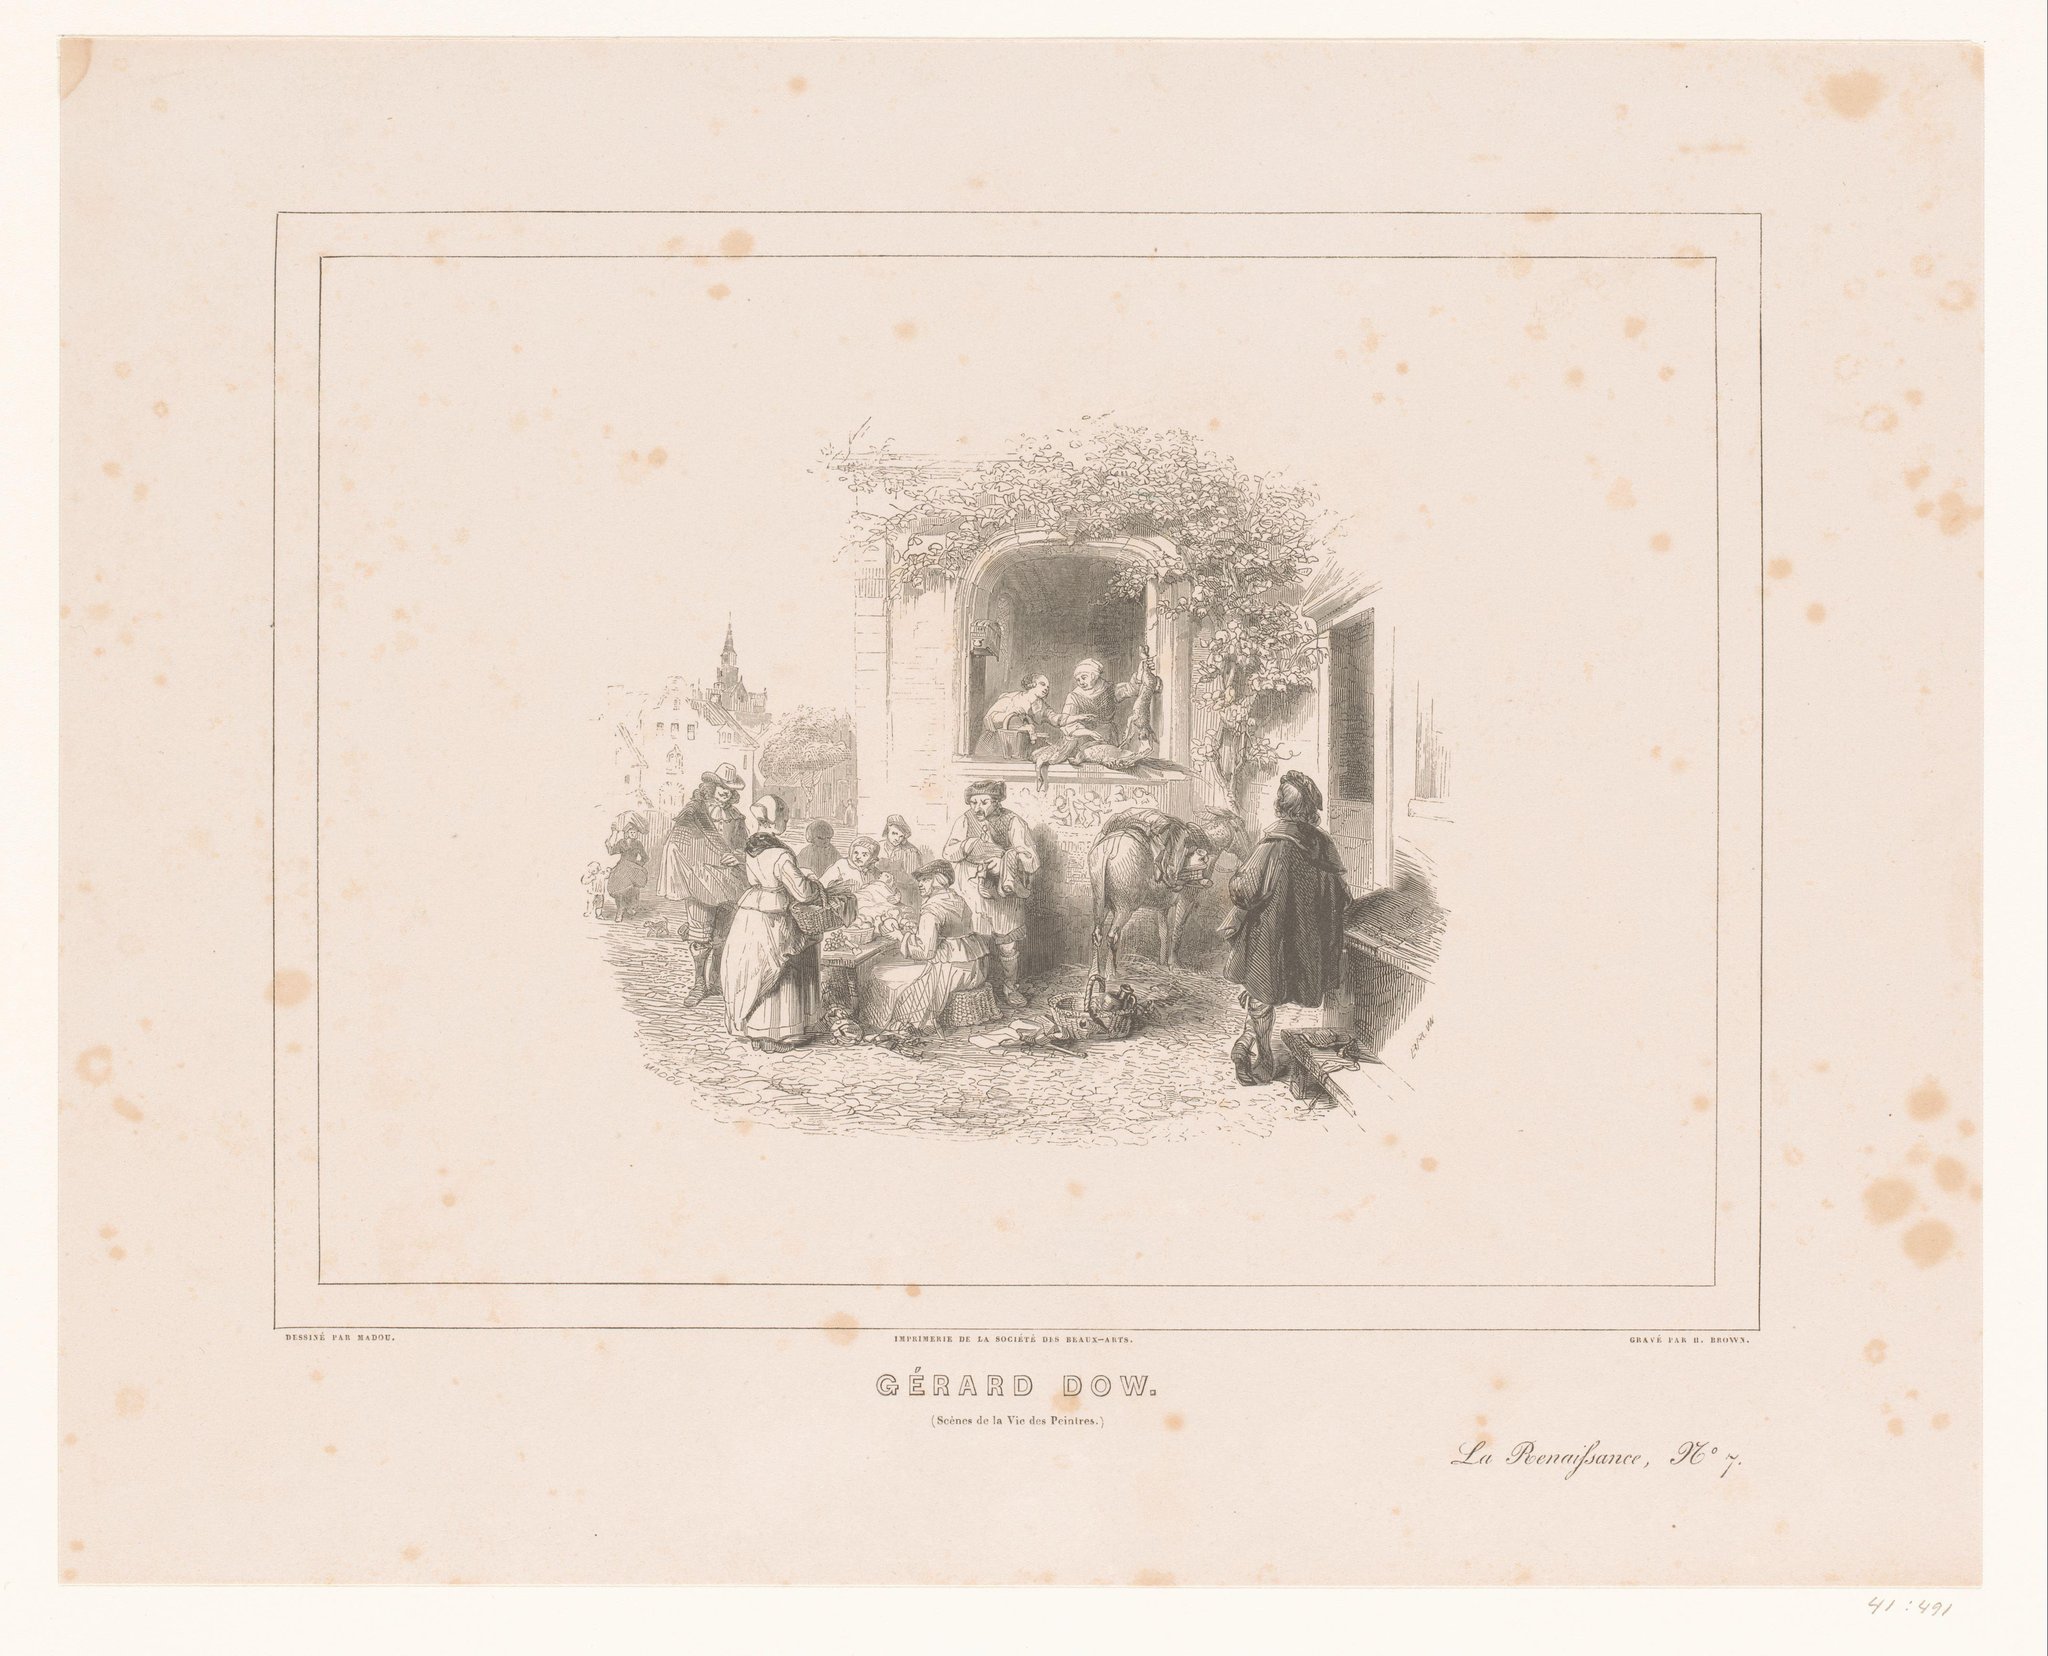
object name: print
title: Gérard Dow (scènes de la Vie des Peintres)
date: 1826-1870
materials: paper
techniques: engraving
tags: leiden, painter, draughtsman, gerard dou, preparation of food - cc - in the open air, ass, donkey, family, relationship, descent, street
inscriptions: collector's mark: Lugt 2760, collector's mark: Lugt 2228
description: Prent is verschenen in een uitgave van: La Renaissance. Chronique des arts et de la littérature [1839-1849], pl. 7.